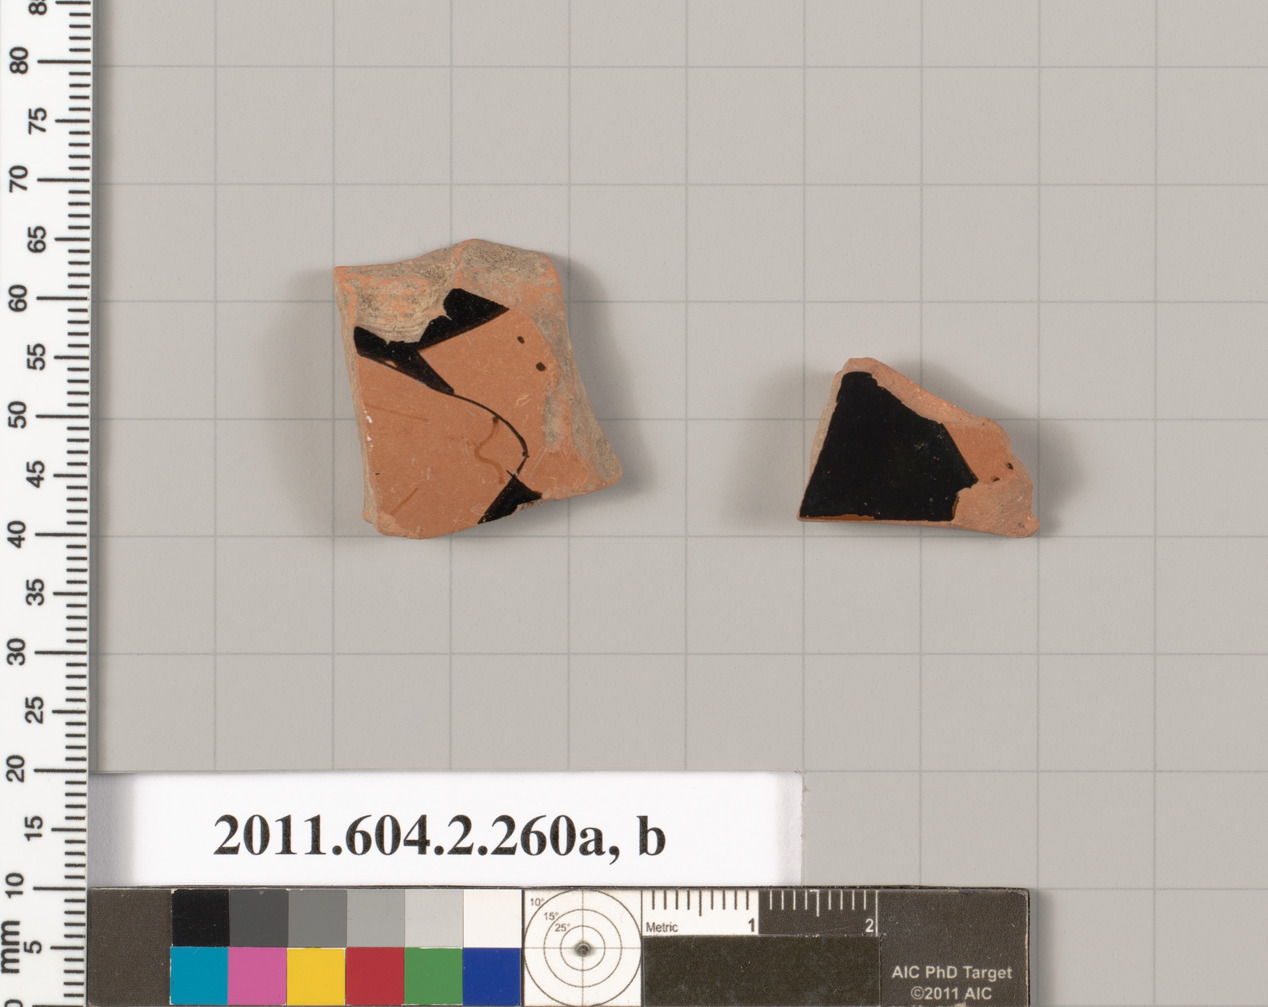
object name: stamnos fragment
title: Terracotta fragments of a stamnos (jar)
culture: greek, attic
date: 490-470 BCE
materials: terracotta